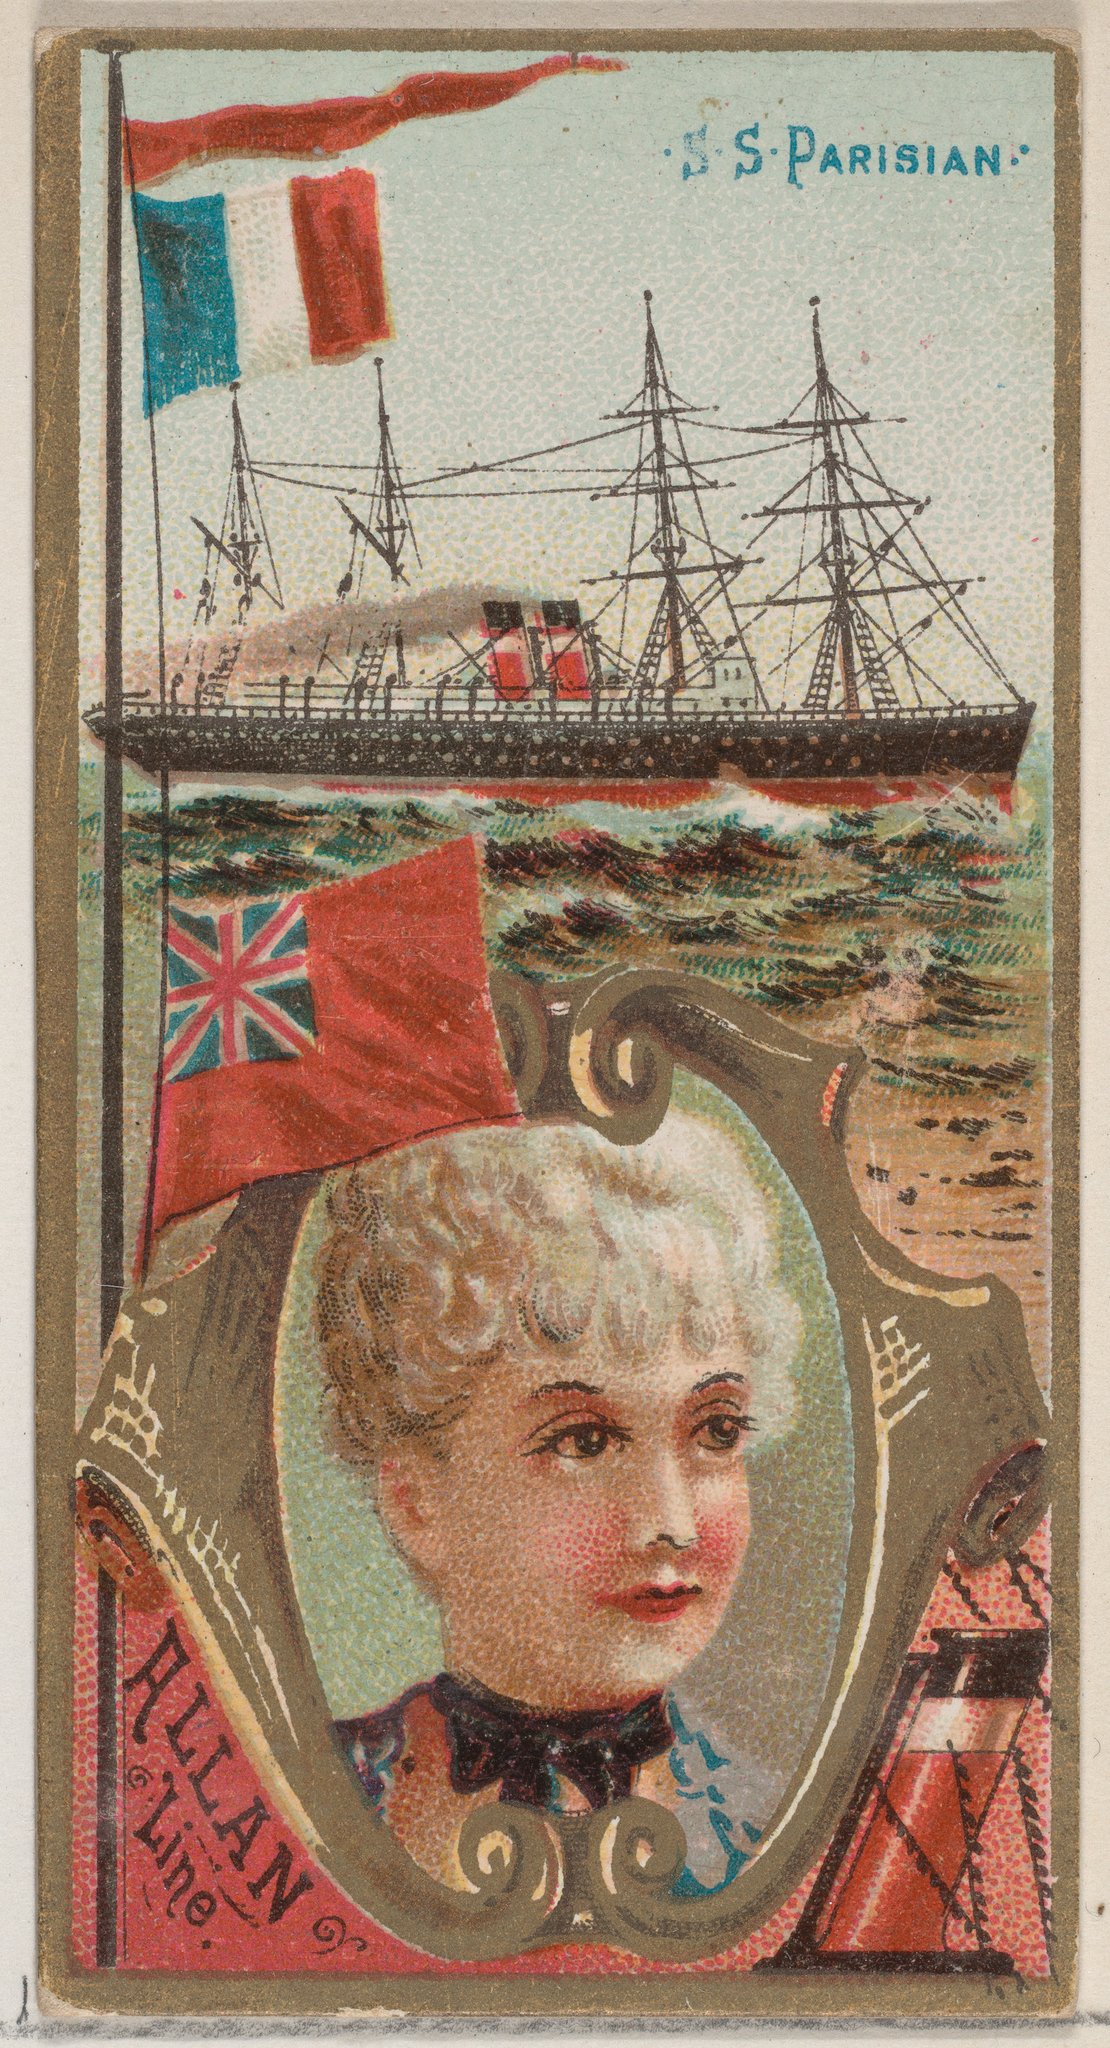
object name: print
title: Steamship Parisian, Allan Line, from the Ocean and River Steamers series (N83) for Duke brand cigarettes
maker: w. duke, sons & co.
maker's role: publisher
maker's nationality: american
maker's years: 1870-1920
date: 1887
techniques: color lithograph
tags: women,ships